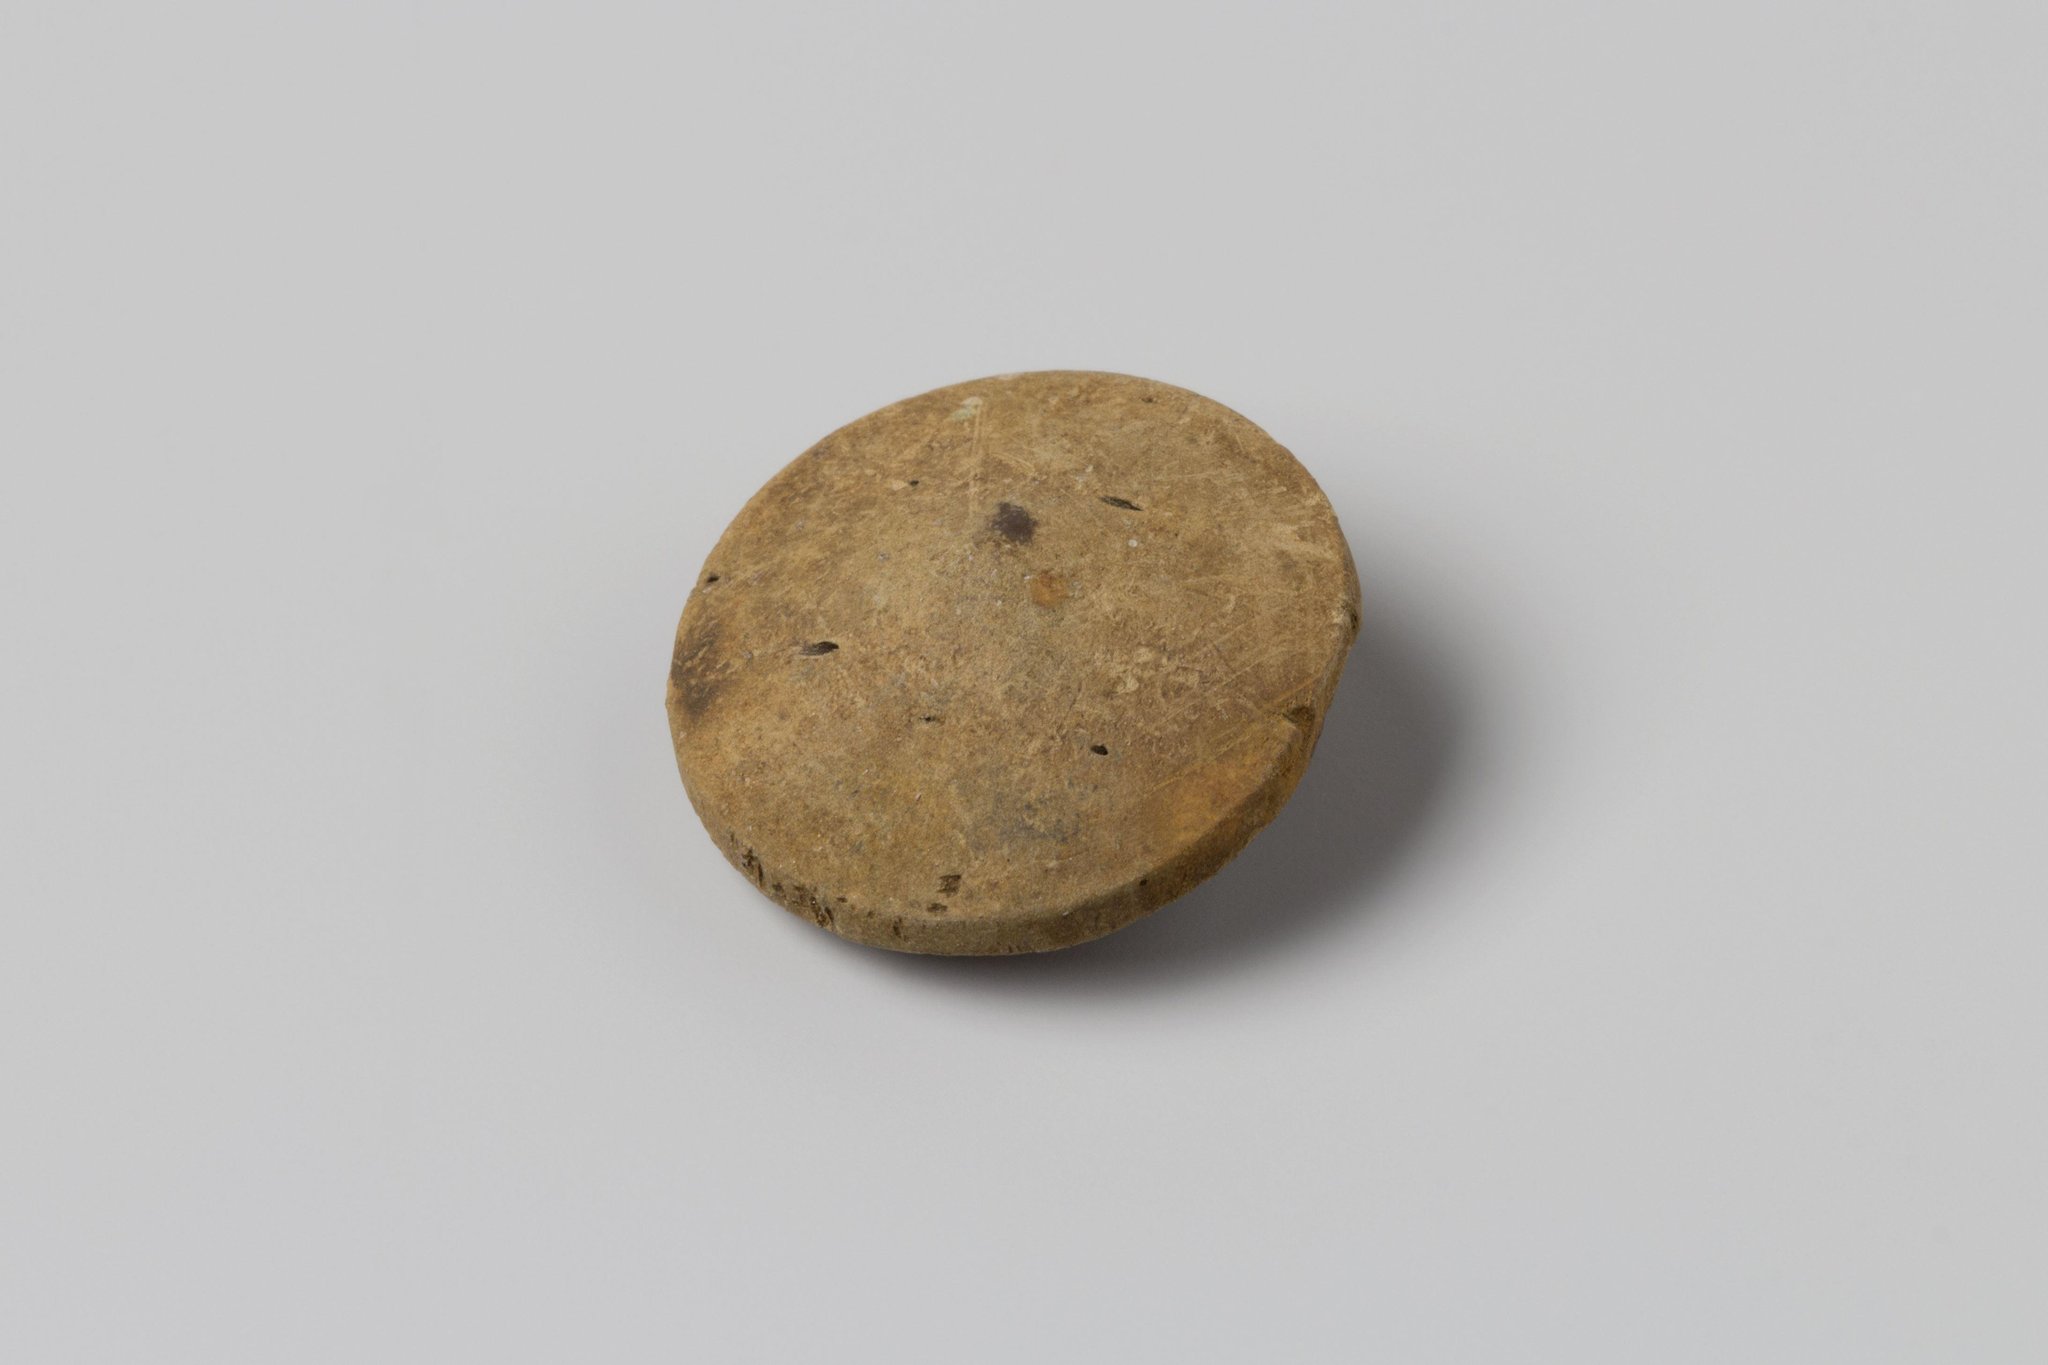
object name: button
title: Knoop uit het wrak van de Oost-Indiëvaarder Hollandia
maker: Anonymous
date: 1700-1743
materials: bone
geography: netherlands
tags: verenigde oostindische compagnie, hollandia (schip), annet